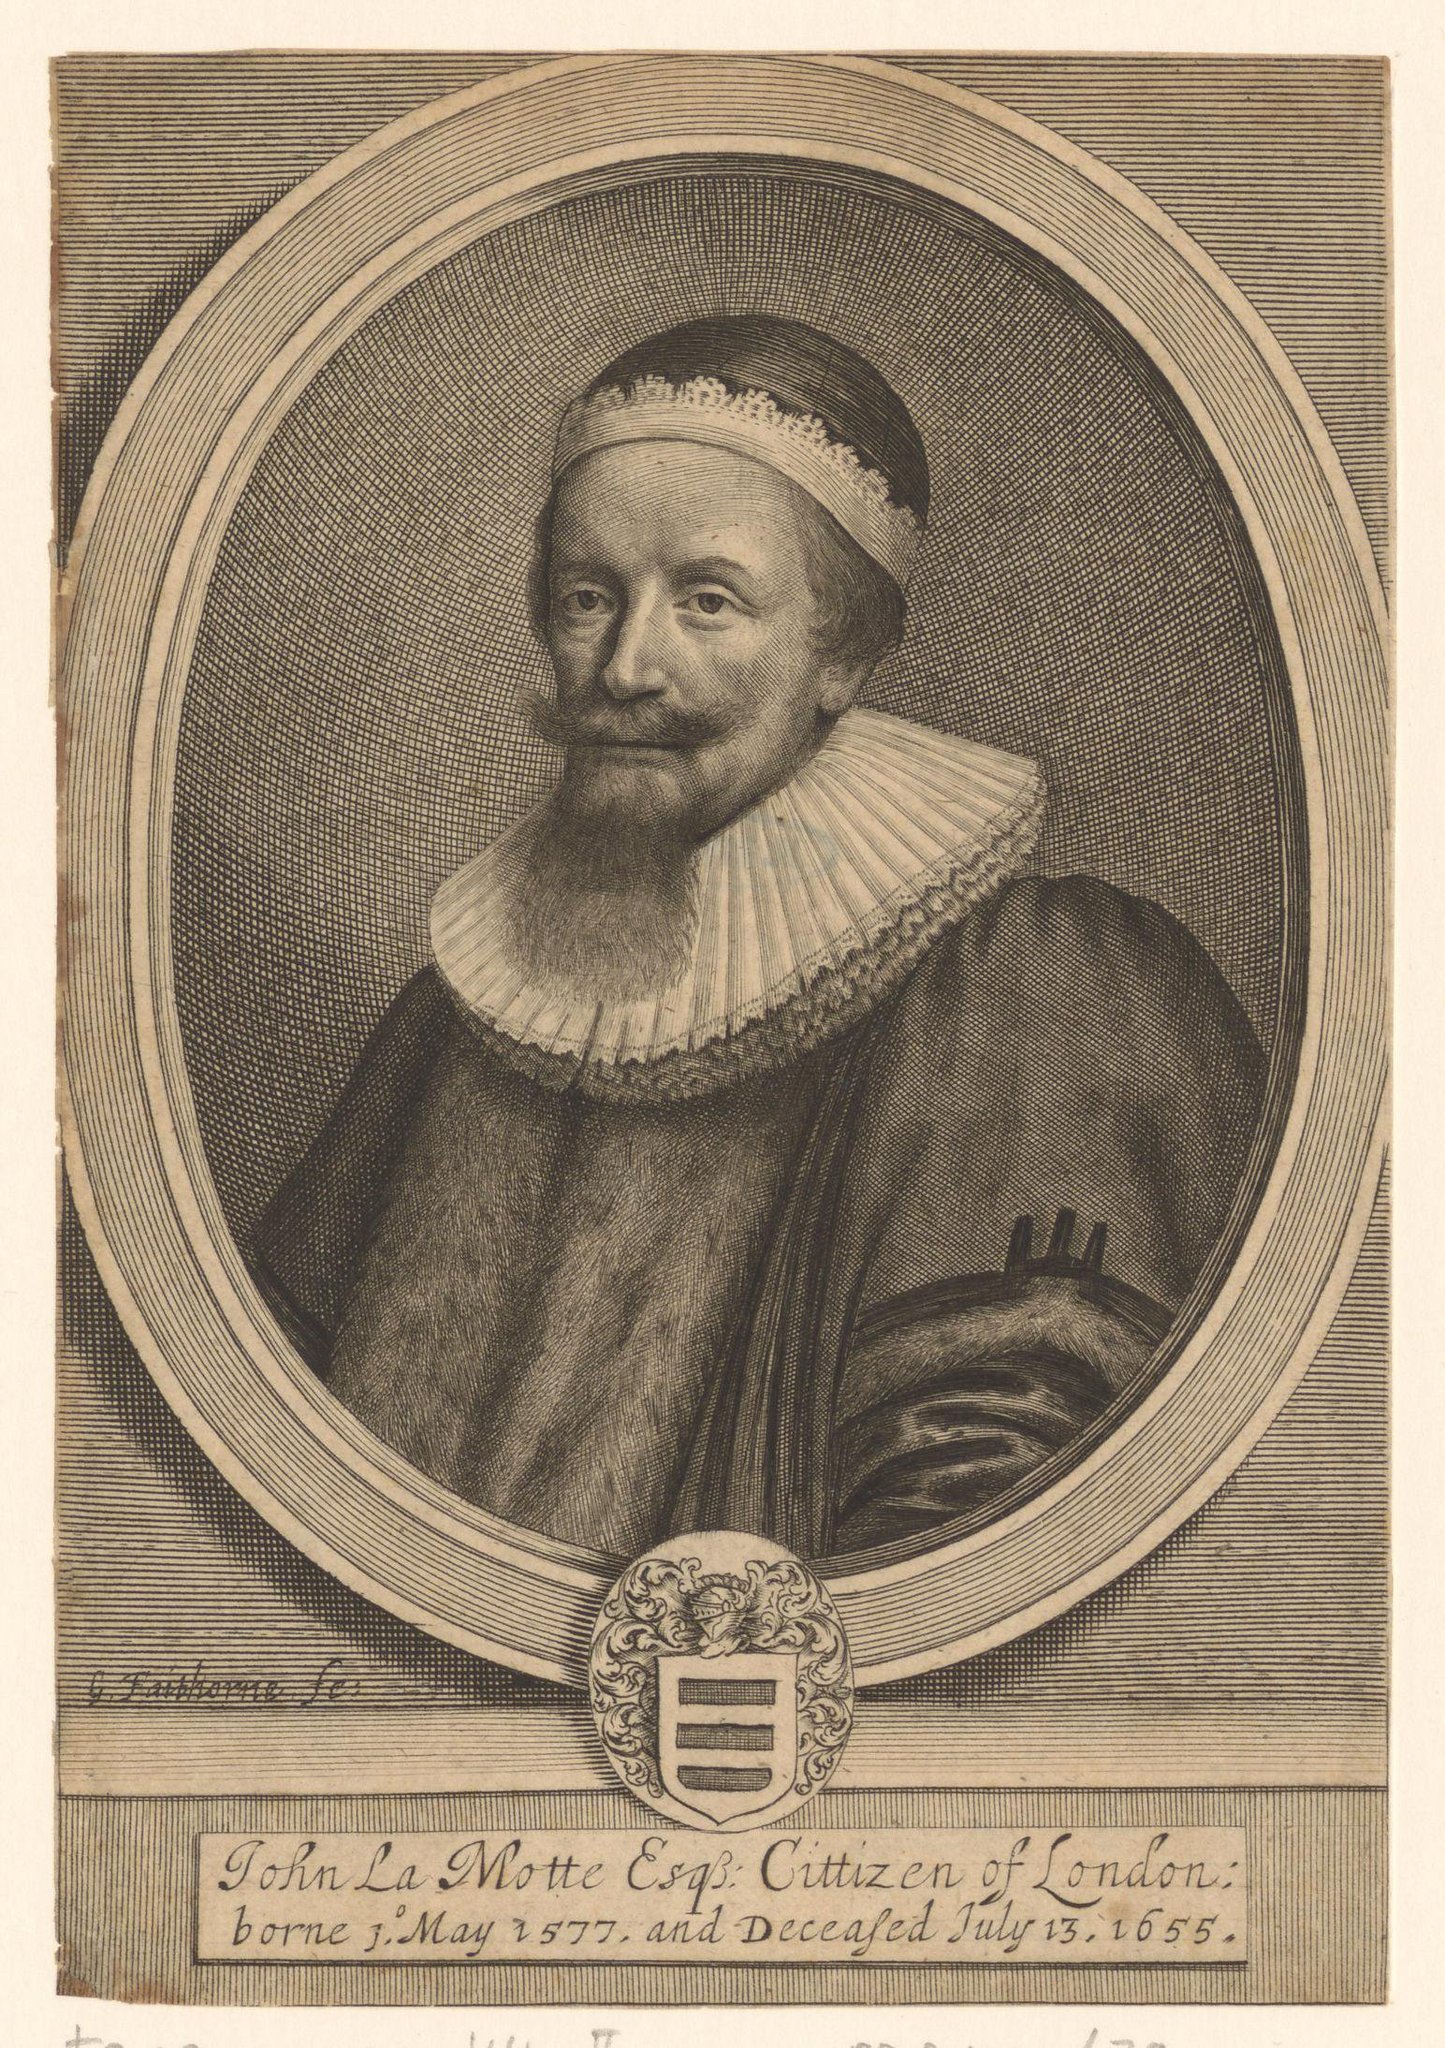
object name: print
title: Portret van John la Motte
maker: william faithorne (i)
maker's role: print maker, publisher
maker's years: 1616-1691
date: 1656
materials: paper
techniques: engraving, etching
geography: london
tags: historical persons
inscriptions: collector's mark: Lugt 2228, collector's mark: Lugt 2612, inscription: ‘E du: Skegg [?] 1809’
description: Prent uit: Bellers, Fulk. Abraham's Interment: or the good Old-mans Buriall in a good Old Age (...). Londen: s.n., 1656.